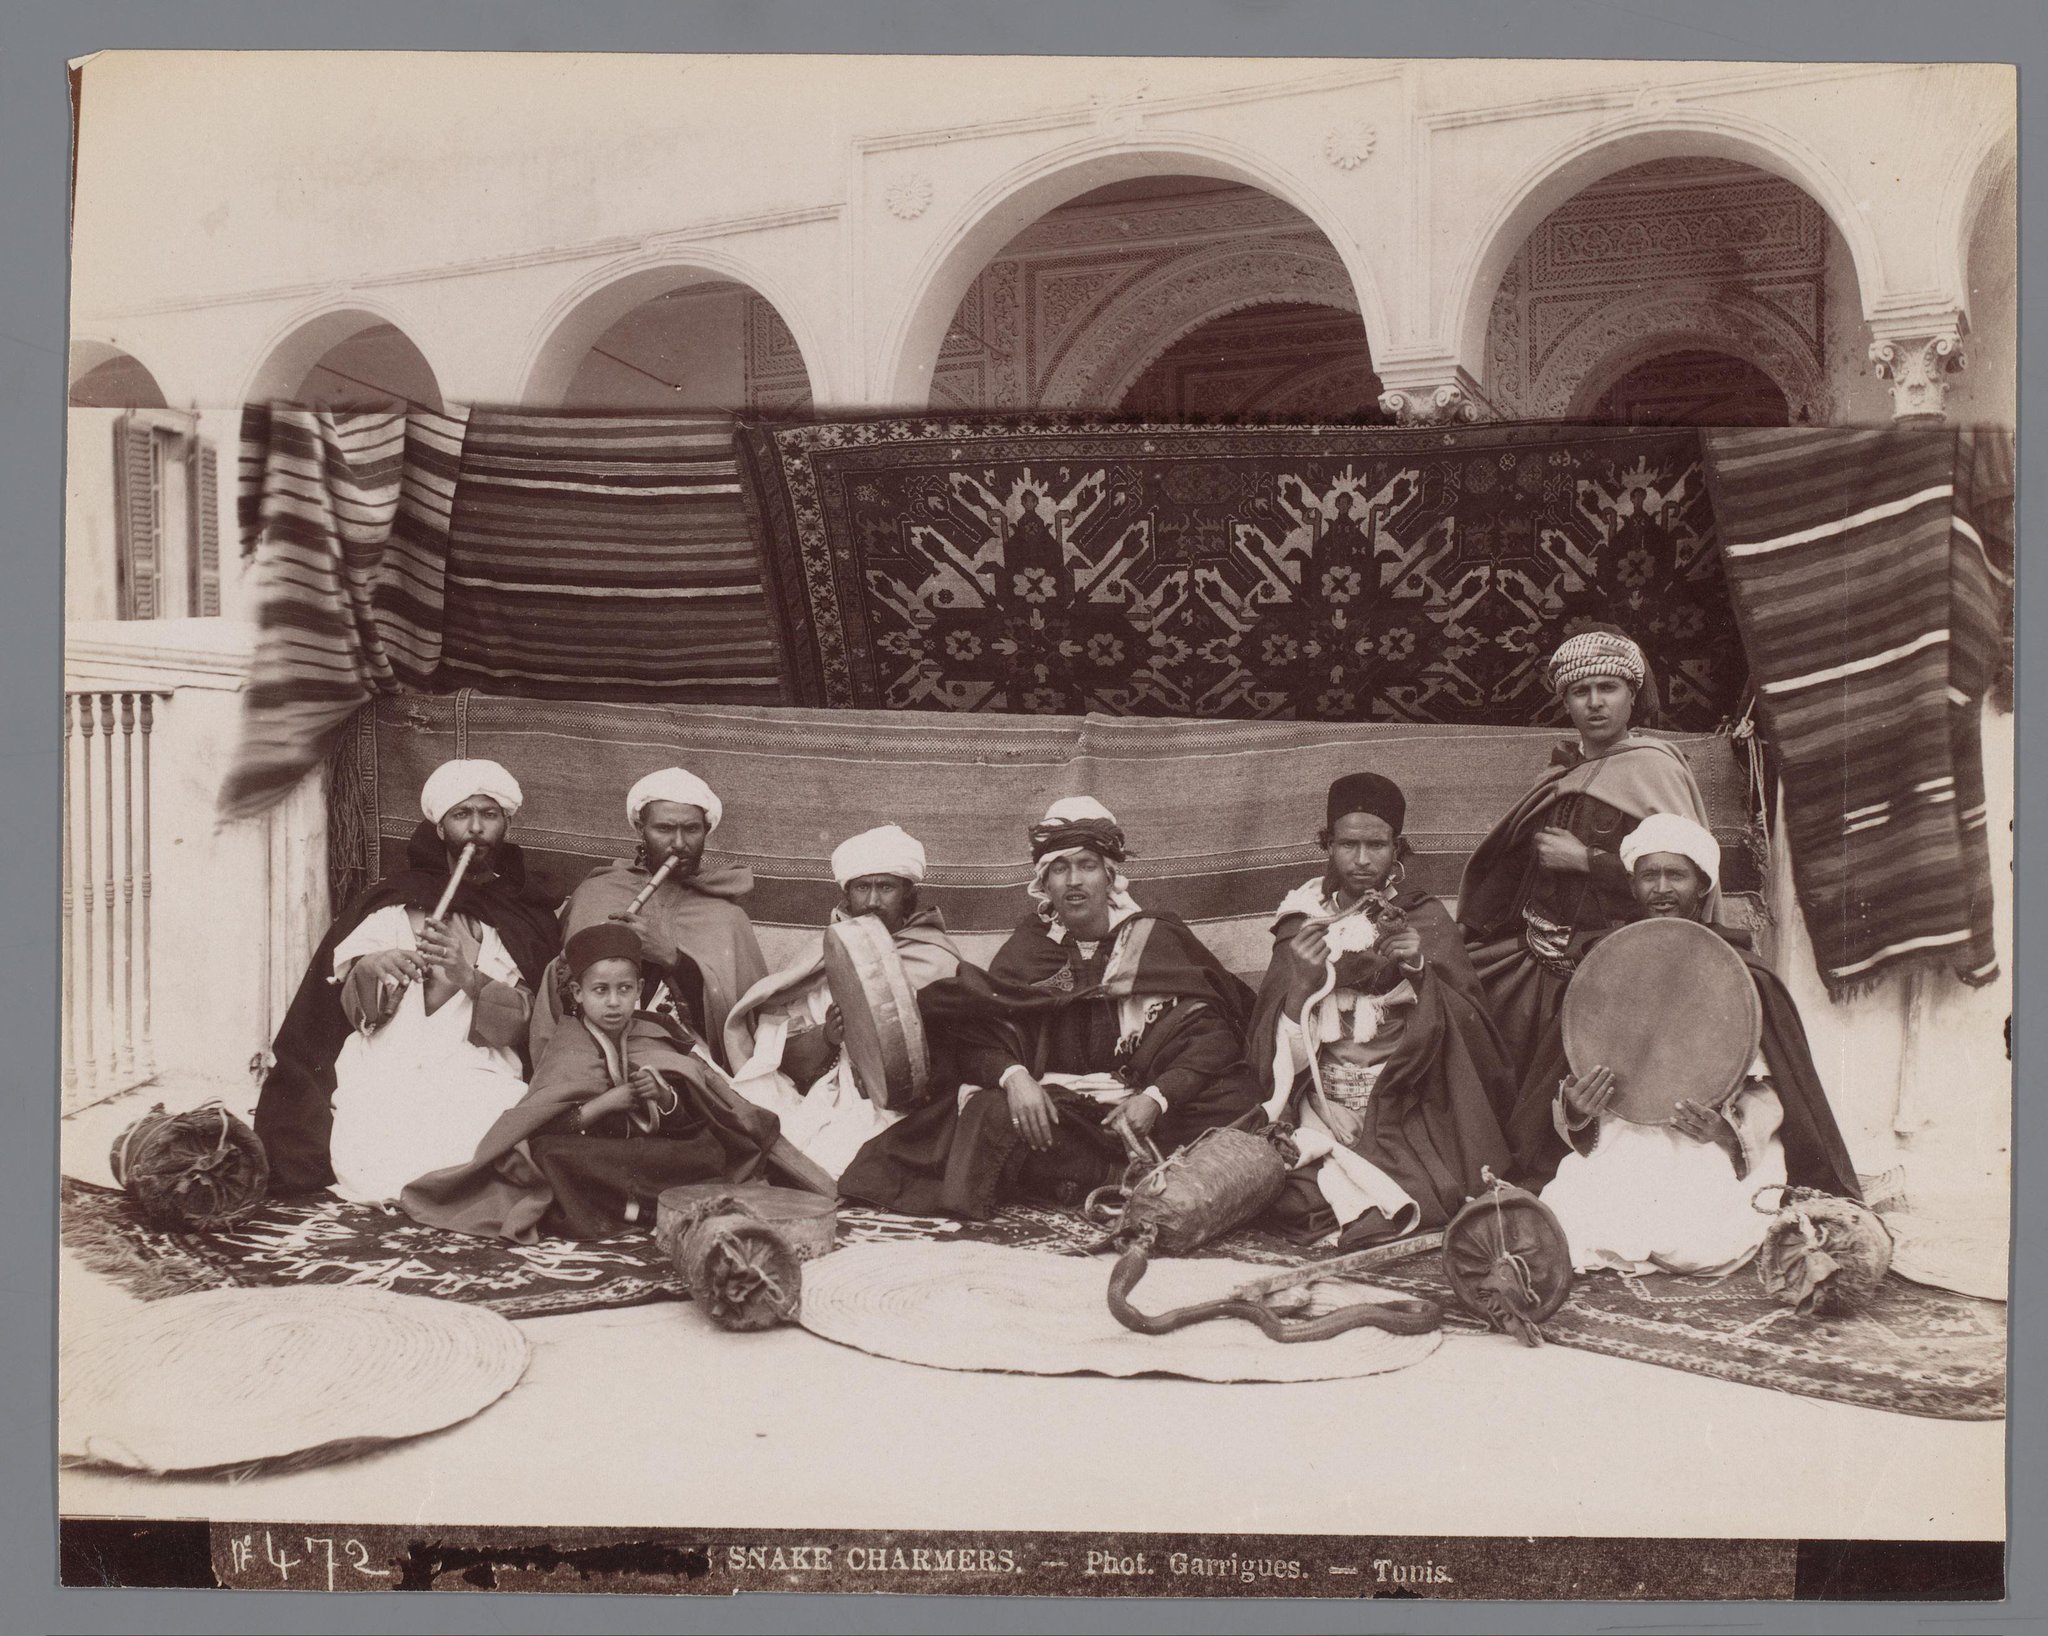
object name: photograph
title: Slangenbezweerders in Tunis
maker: j. andré garrigues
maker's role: fotograaf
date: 1860-1900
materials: paper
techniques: albumen print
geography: tunis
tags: snakes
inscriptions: number: ‘No 472’